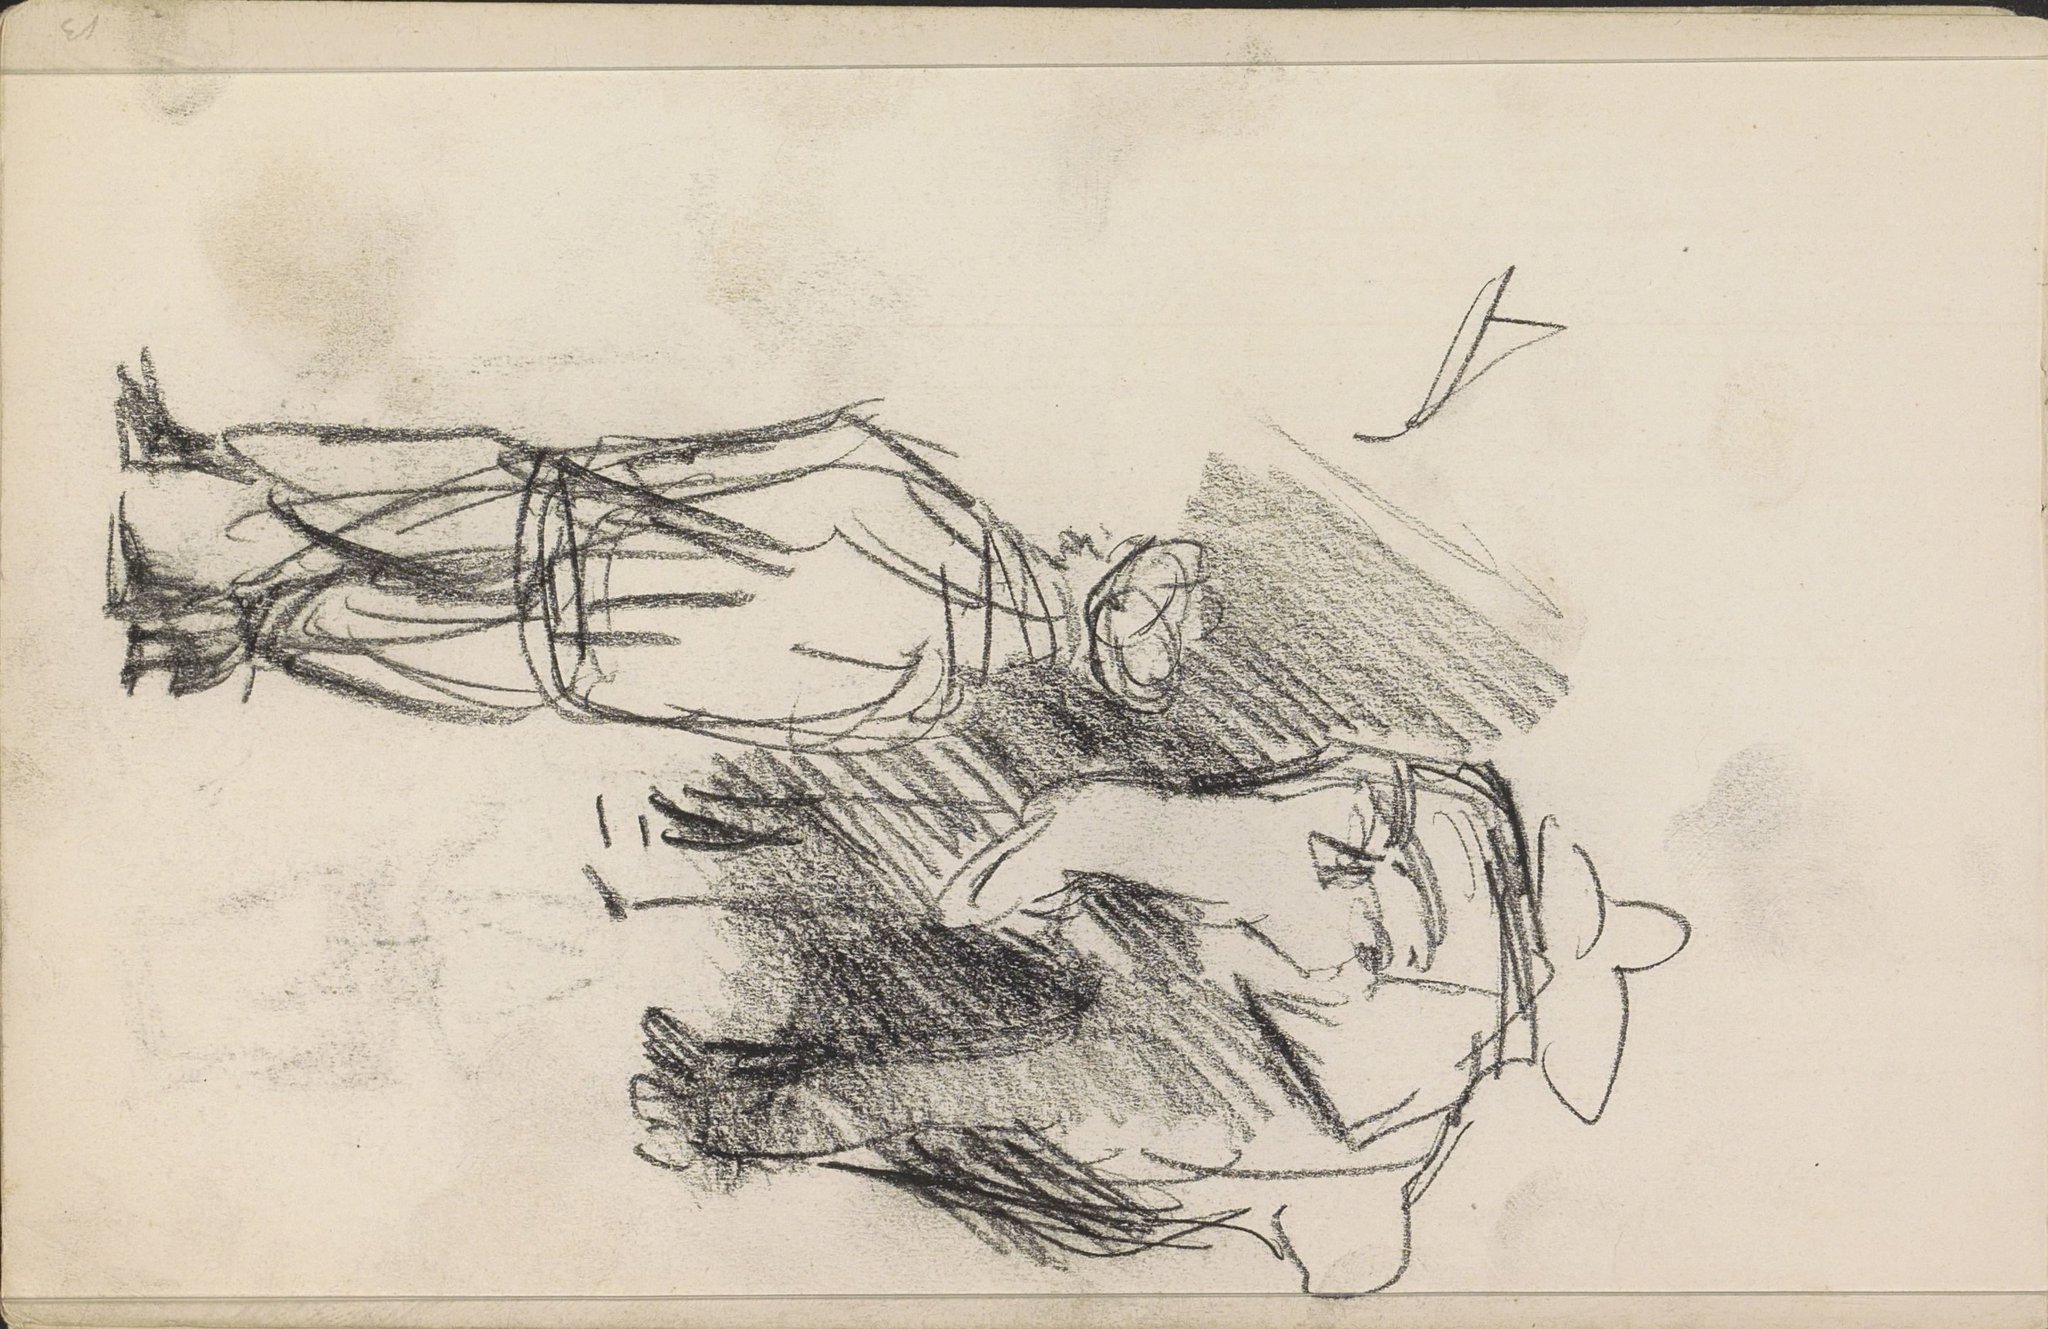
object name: sketchbook leaf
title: Man in oosterse kledij voor een olifant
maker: isaac israels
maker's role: draughtsman, painter, print maker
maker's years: 1865-1934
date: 1875-1934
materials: chalk, paper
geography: paris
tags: adult man (+ standing), folk costume, regional costume, trunked animals: elephant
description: Blad 10 verso uit schetsboek LI met 11 bladen.